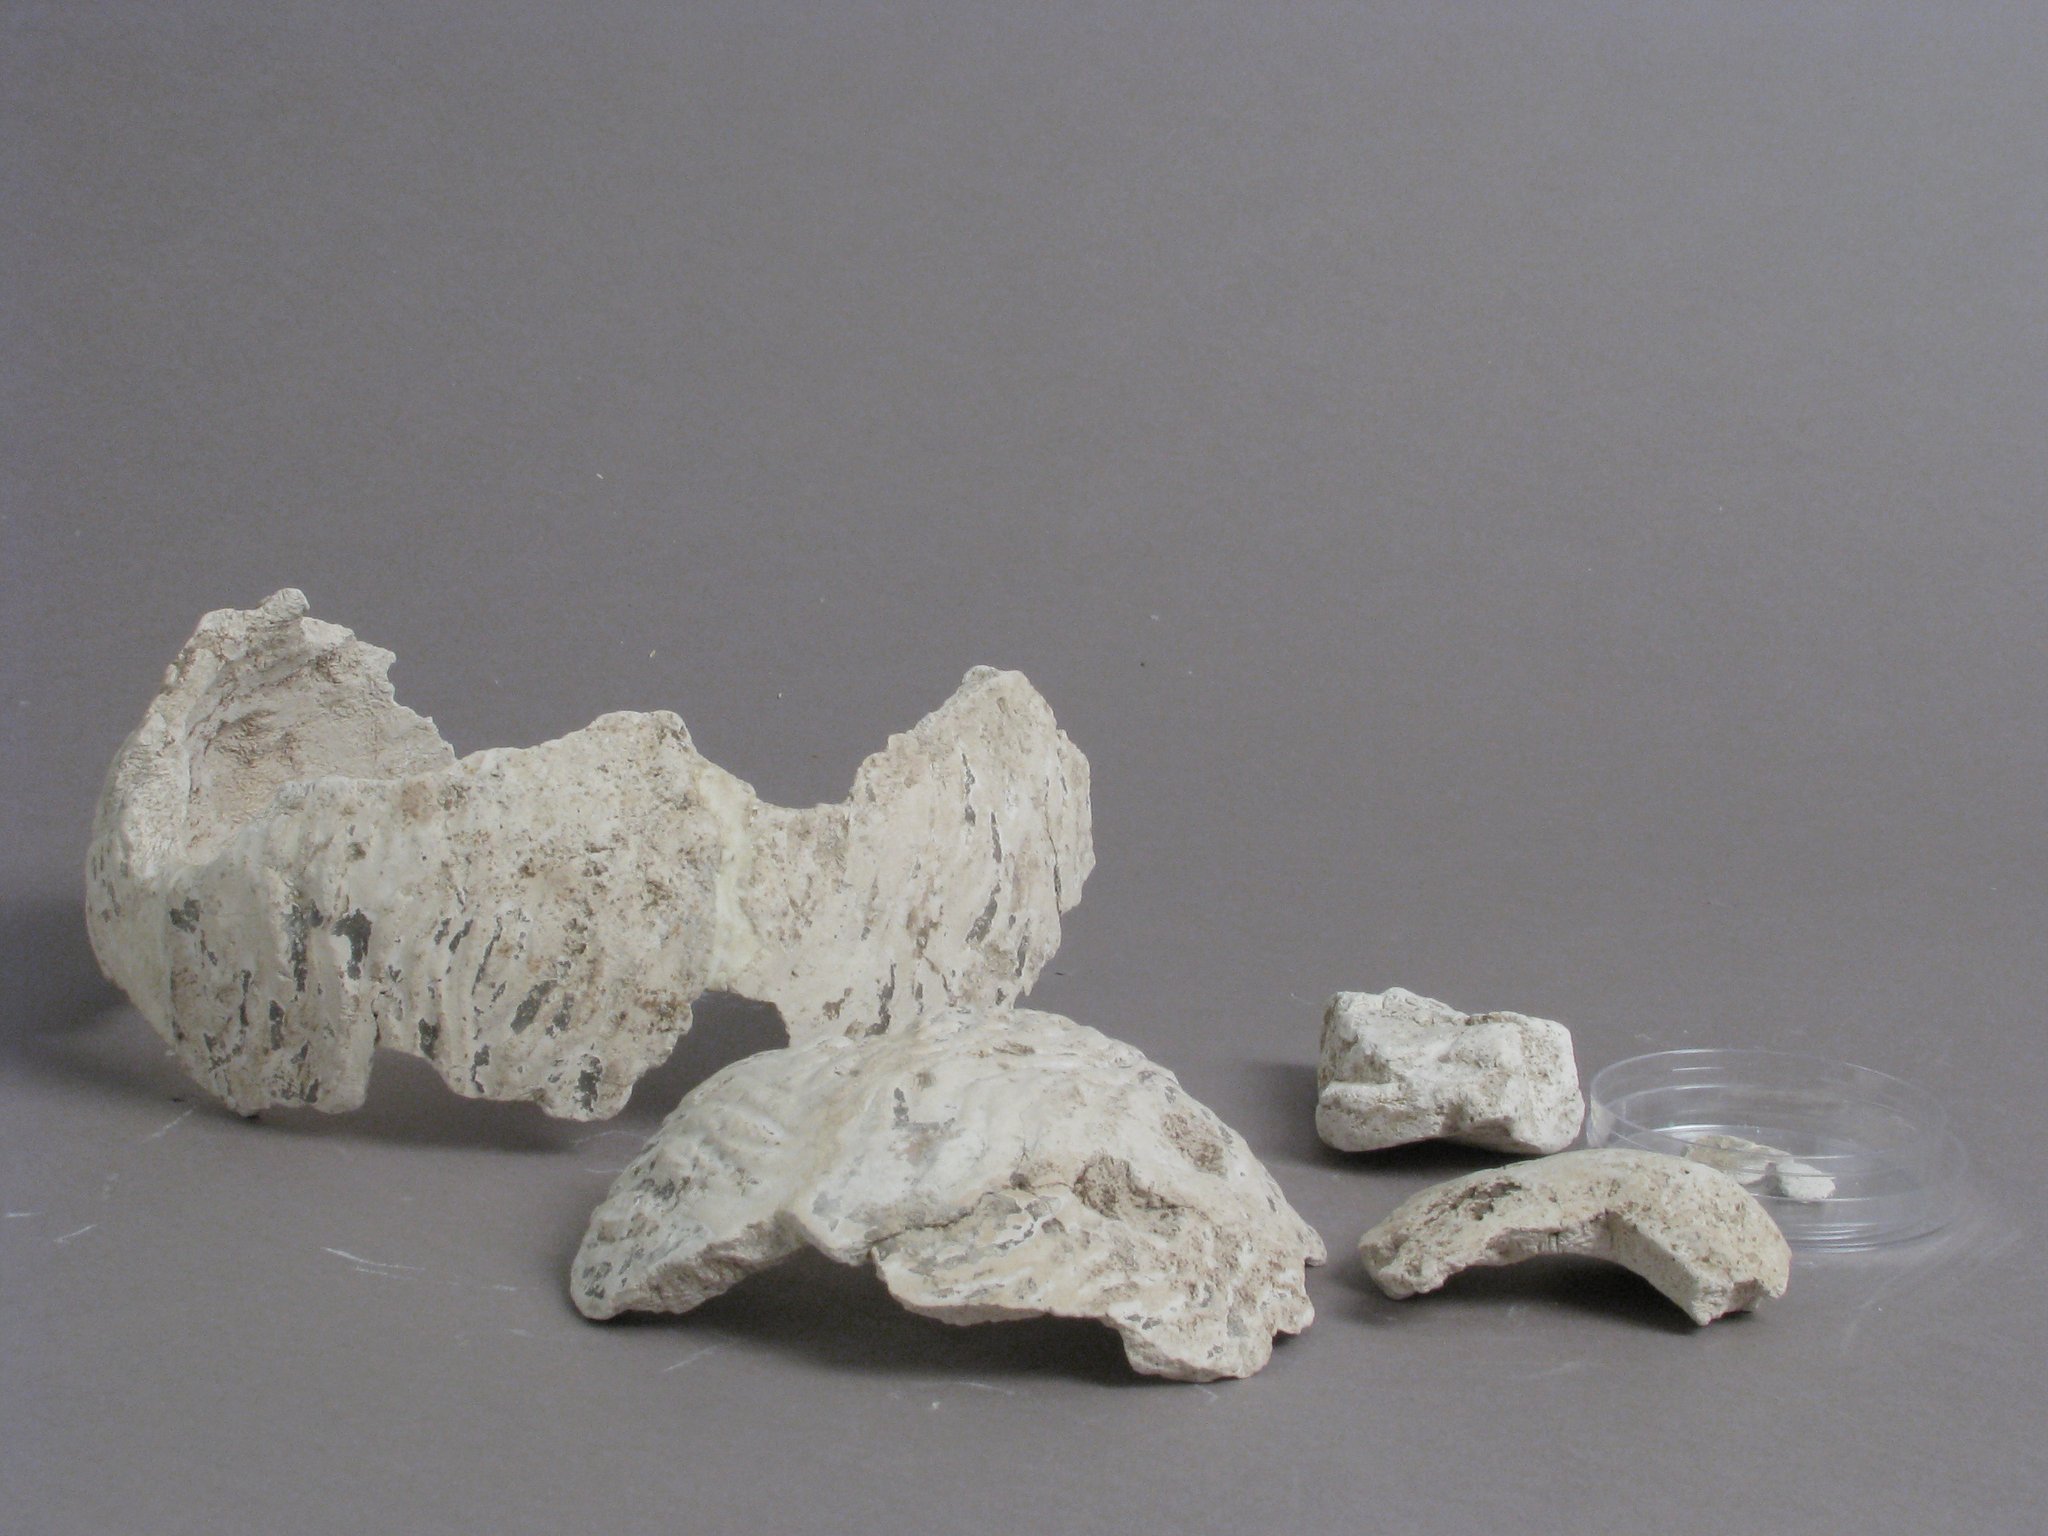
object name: statuette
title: Fragments of a Male Head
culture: coptic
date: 301-700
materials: plaster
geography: egypt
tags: heads